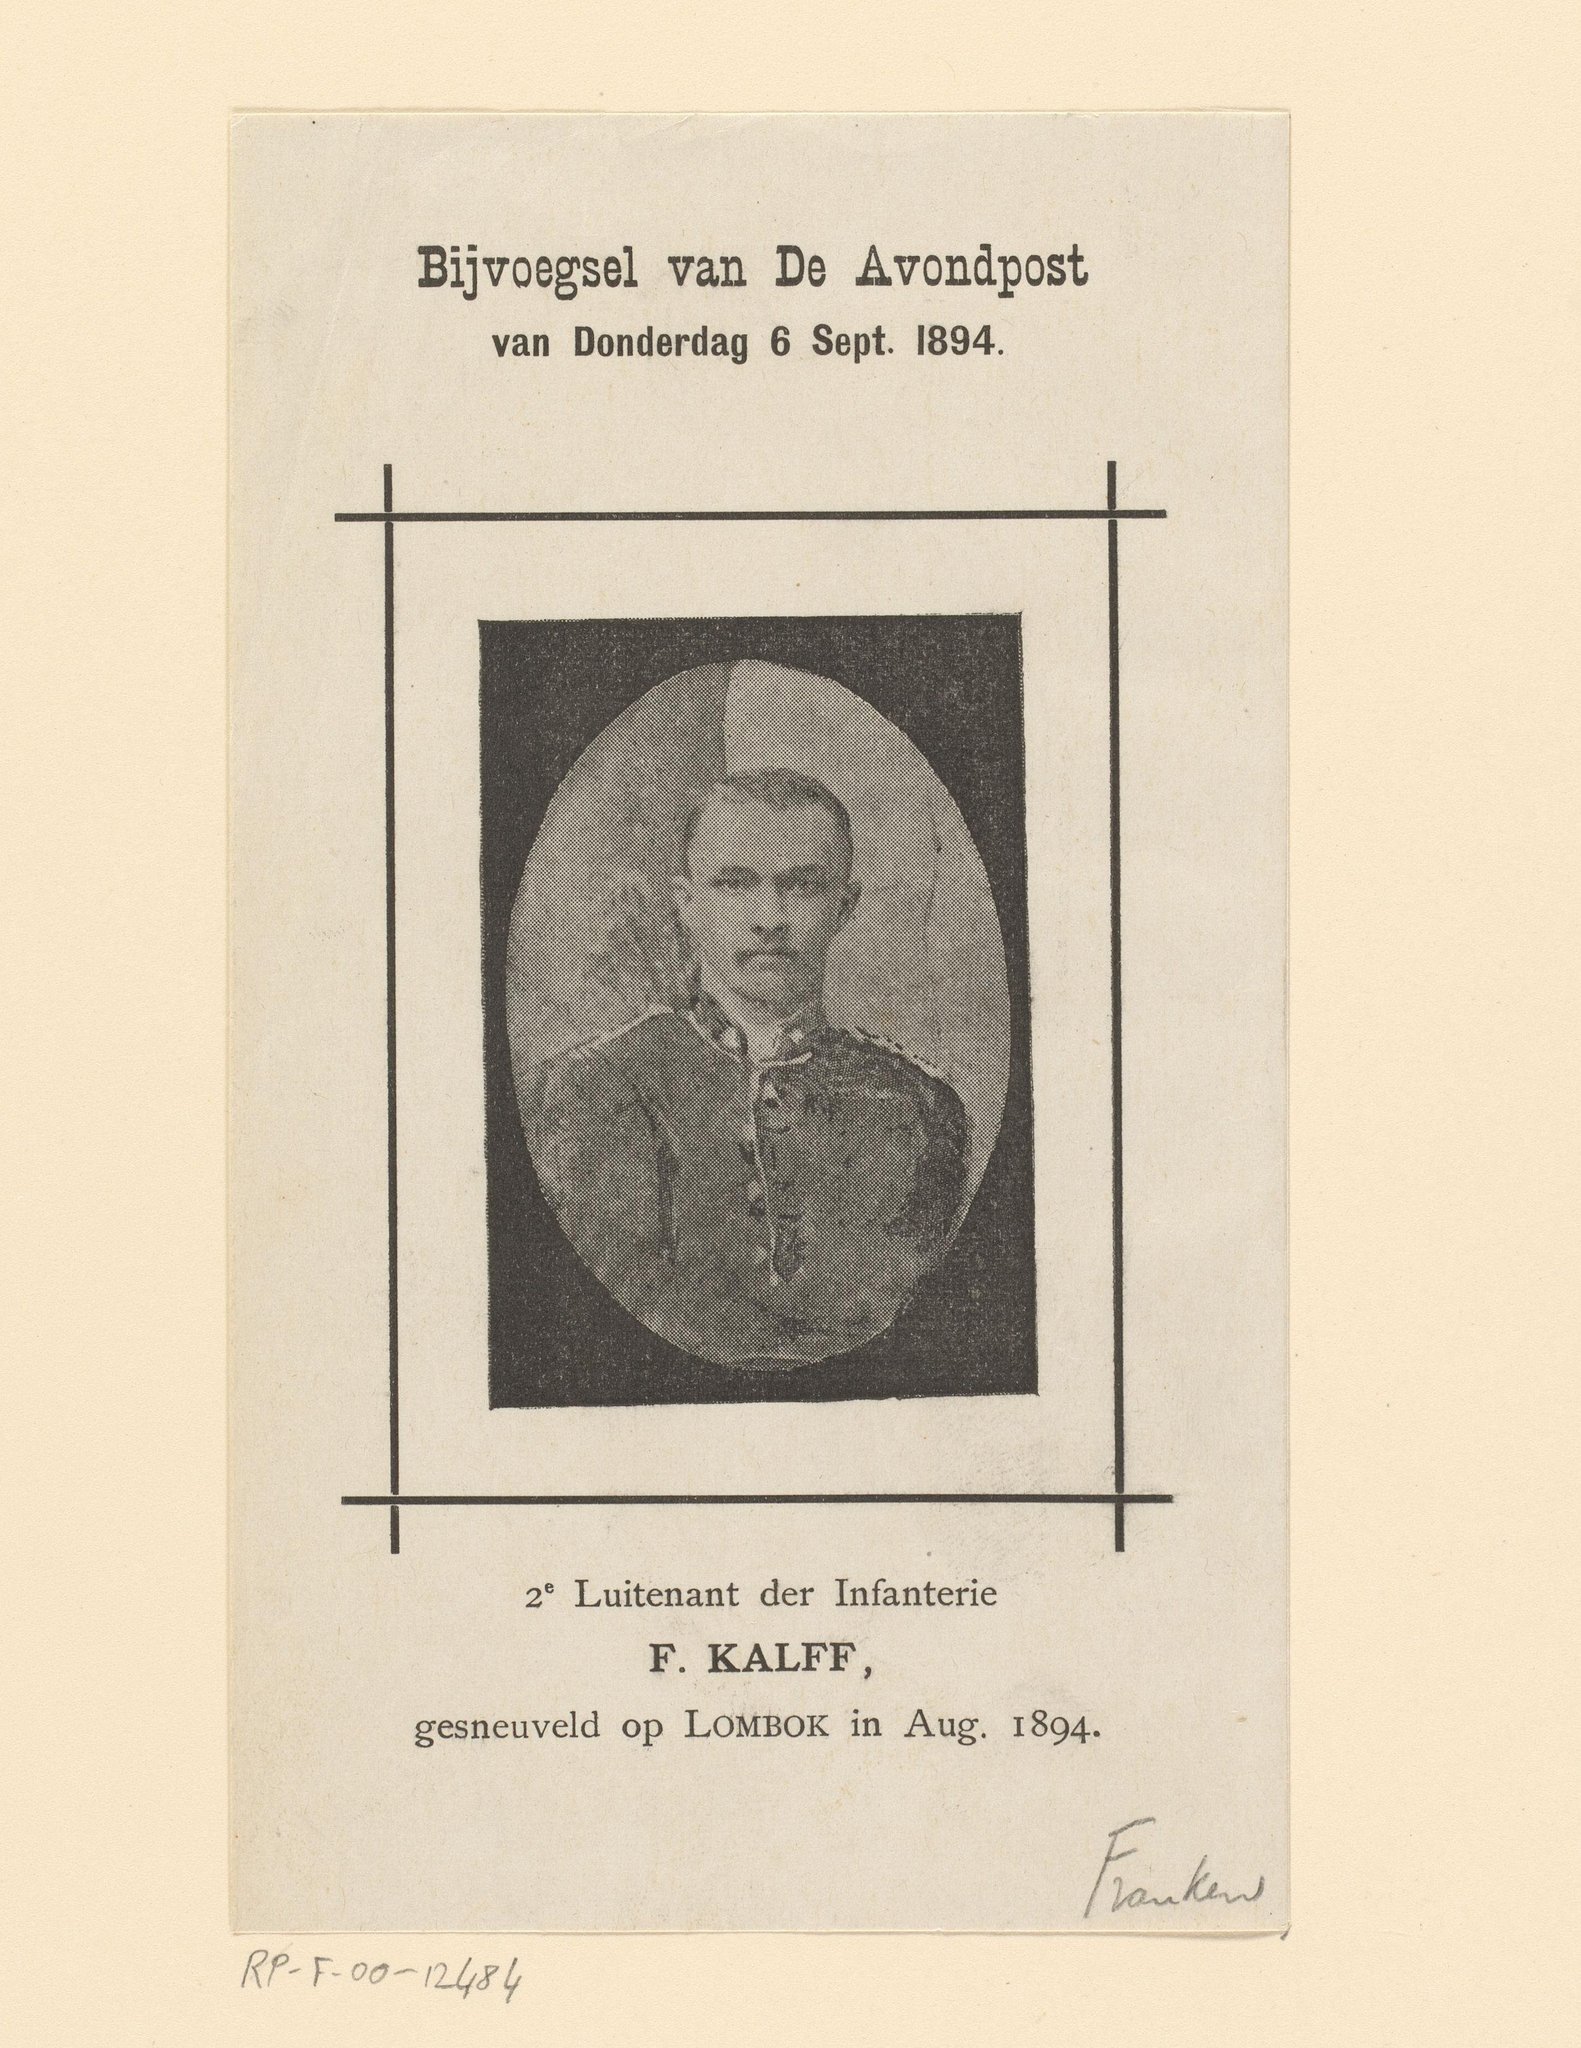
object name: photomechanical print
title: Portret van luitenant Fritz Kalff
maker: Anonymous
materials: paper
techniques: autotype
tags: historical persons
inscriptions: inscription: ‘Bijvoegsel van De Avondpost/ van donderdag 6 sept. 1894.’